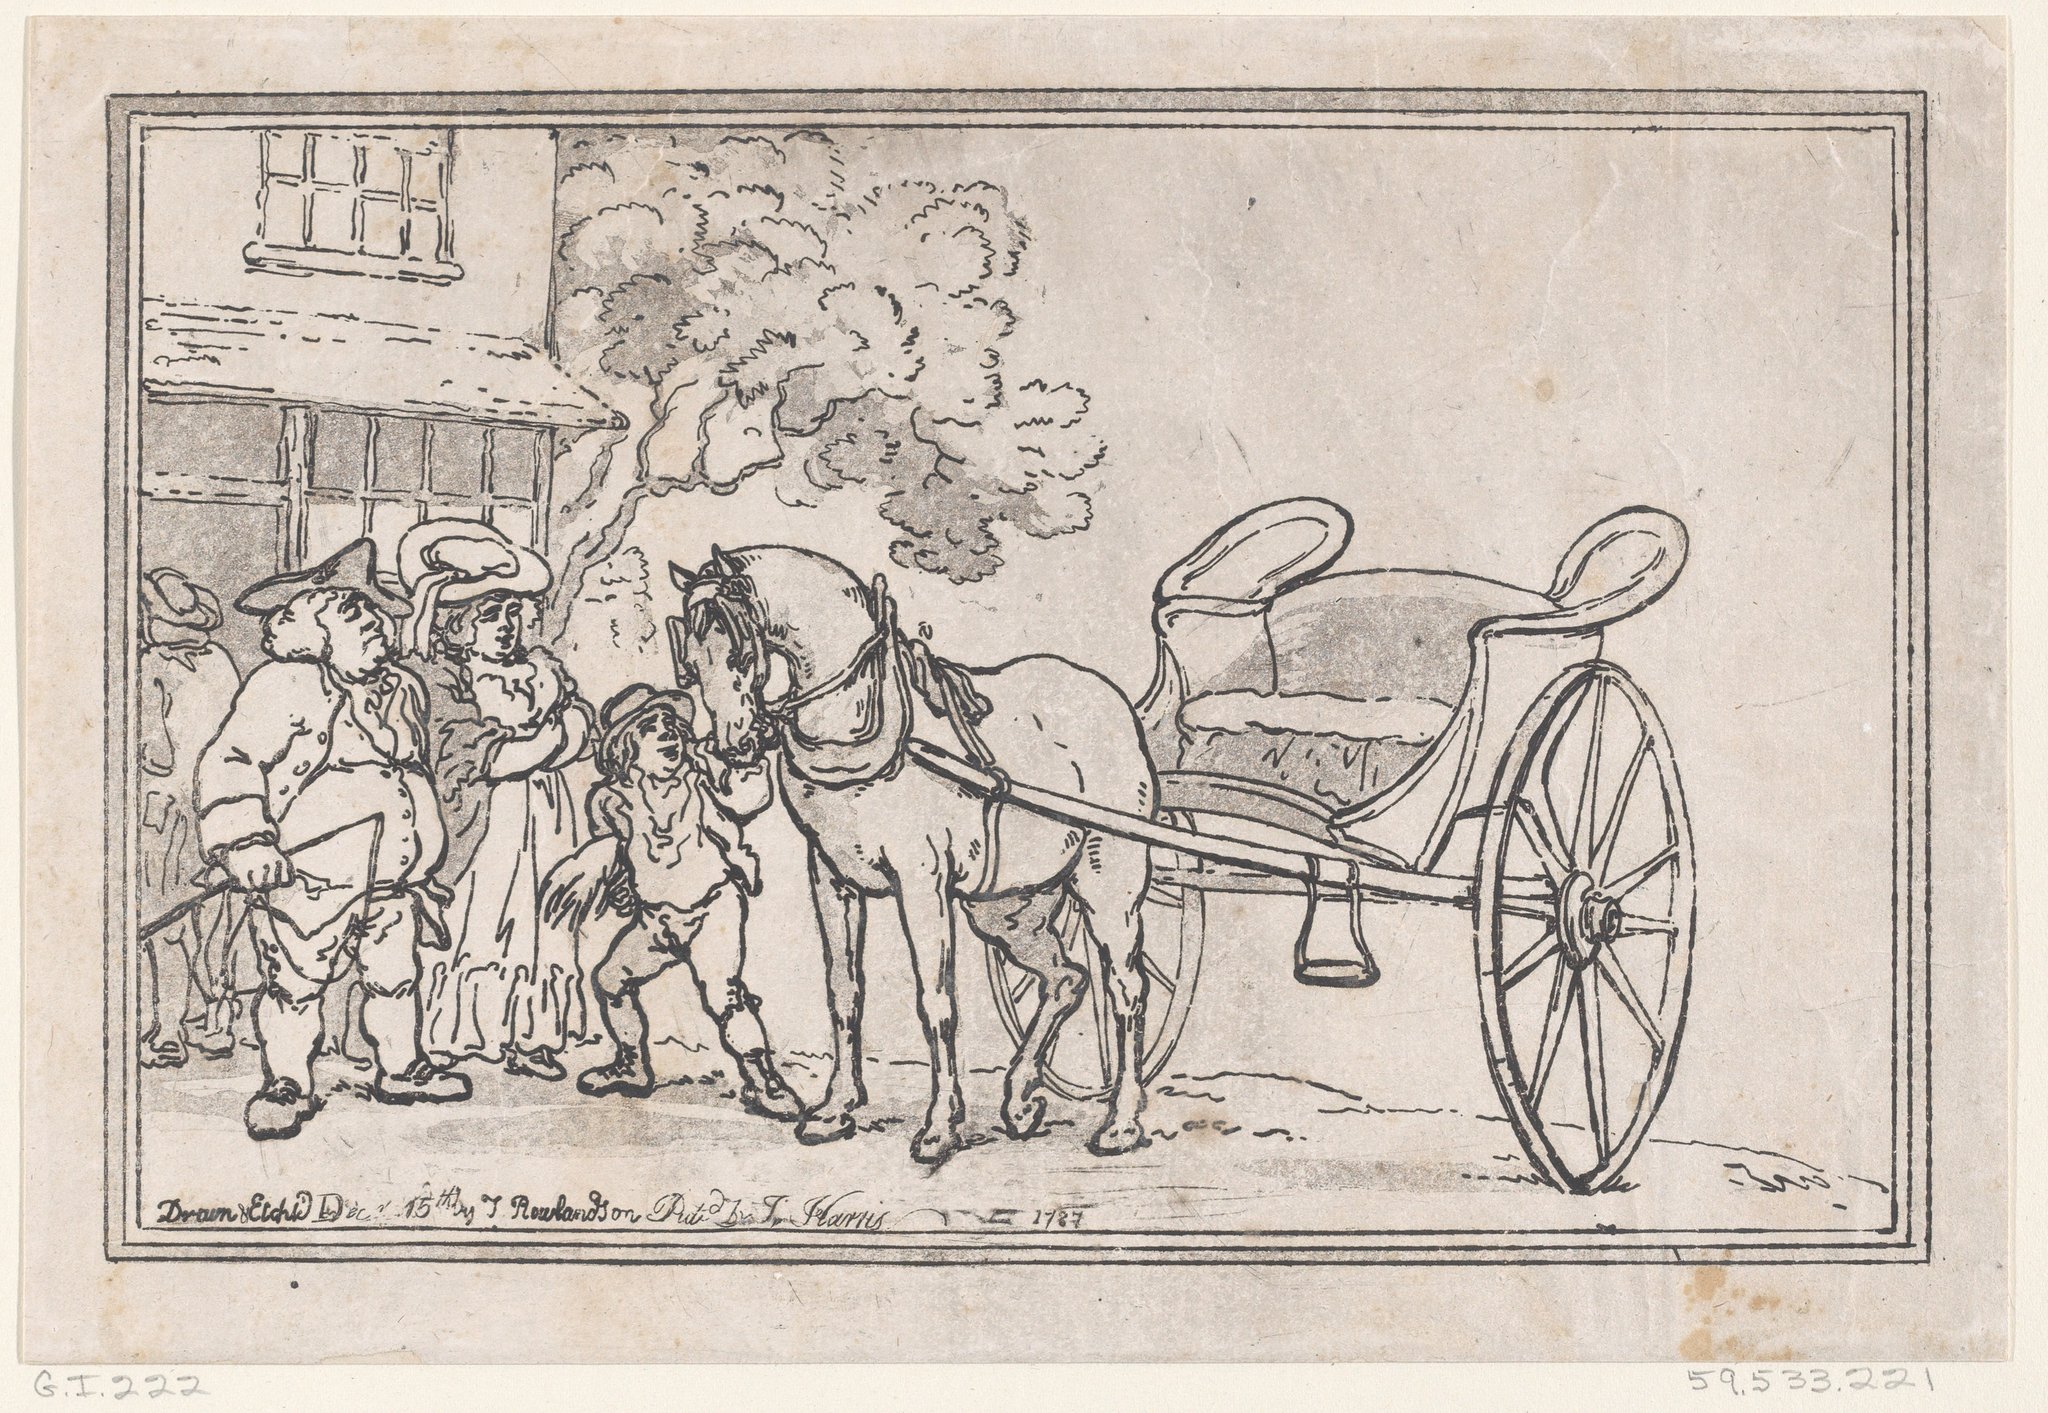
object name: print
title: Boy Bringing Round a Citizen's Curricle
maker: thomas rowlandson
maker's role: artist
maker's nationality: british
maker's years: 1757-1827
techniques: aquatint, etching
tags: men,women,horses,carriages